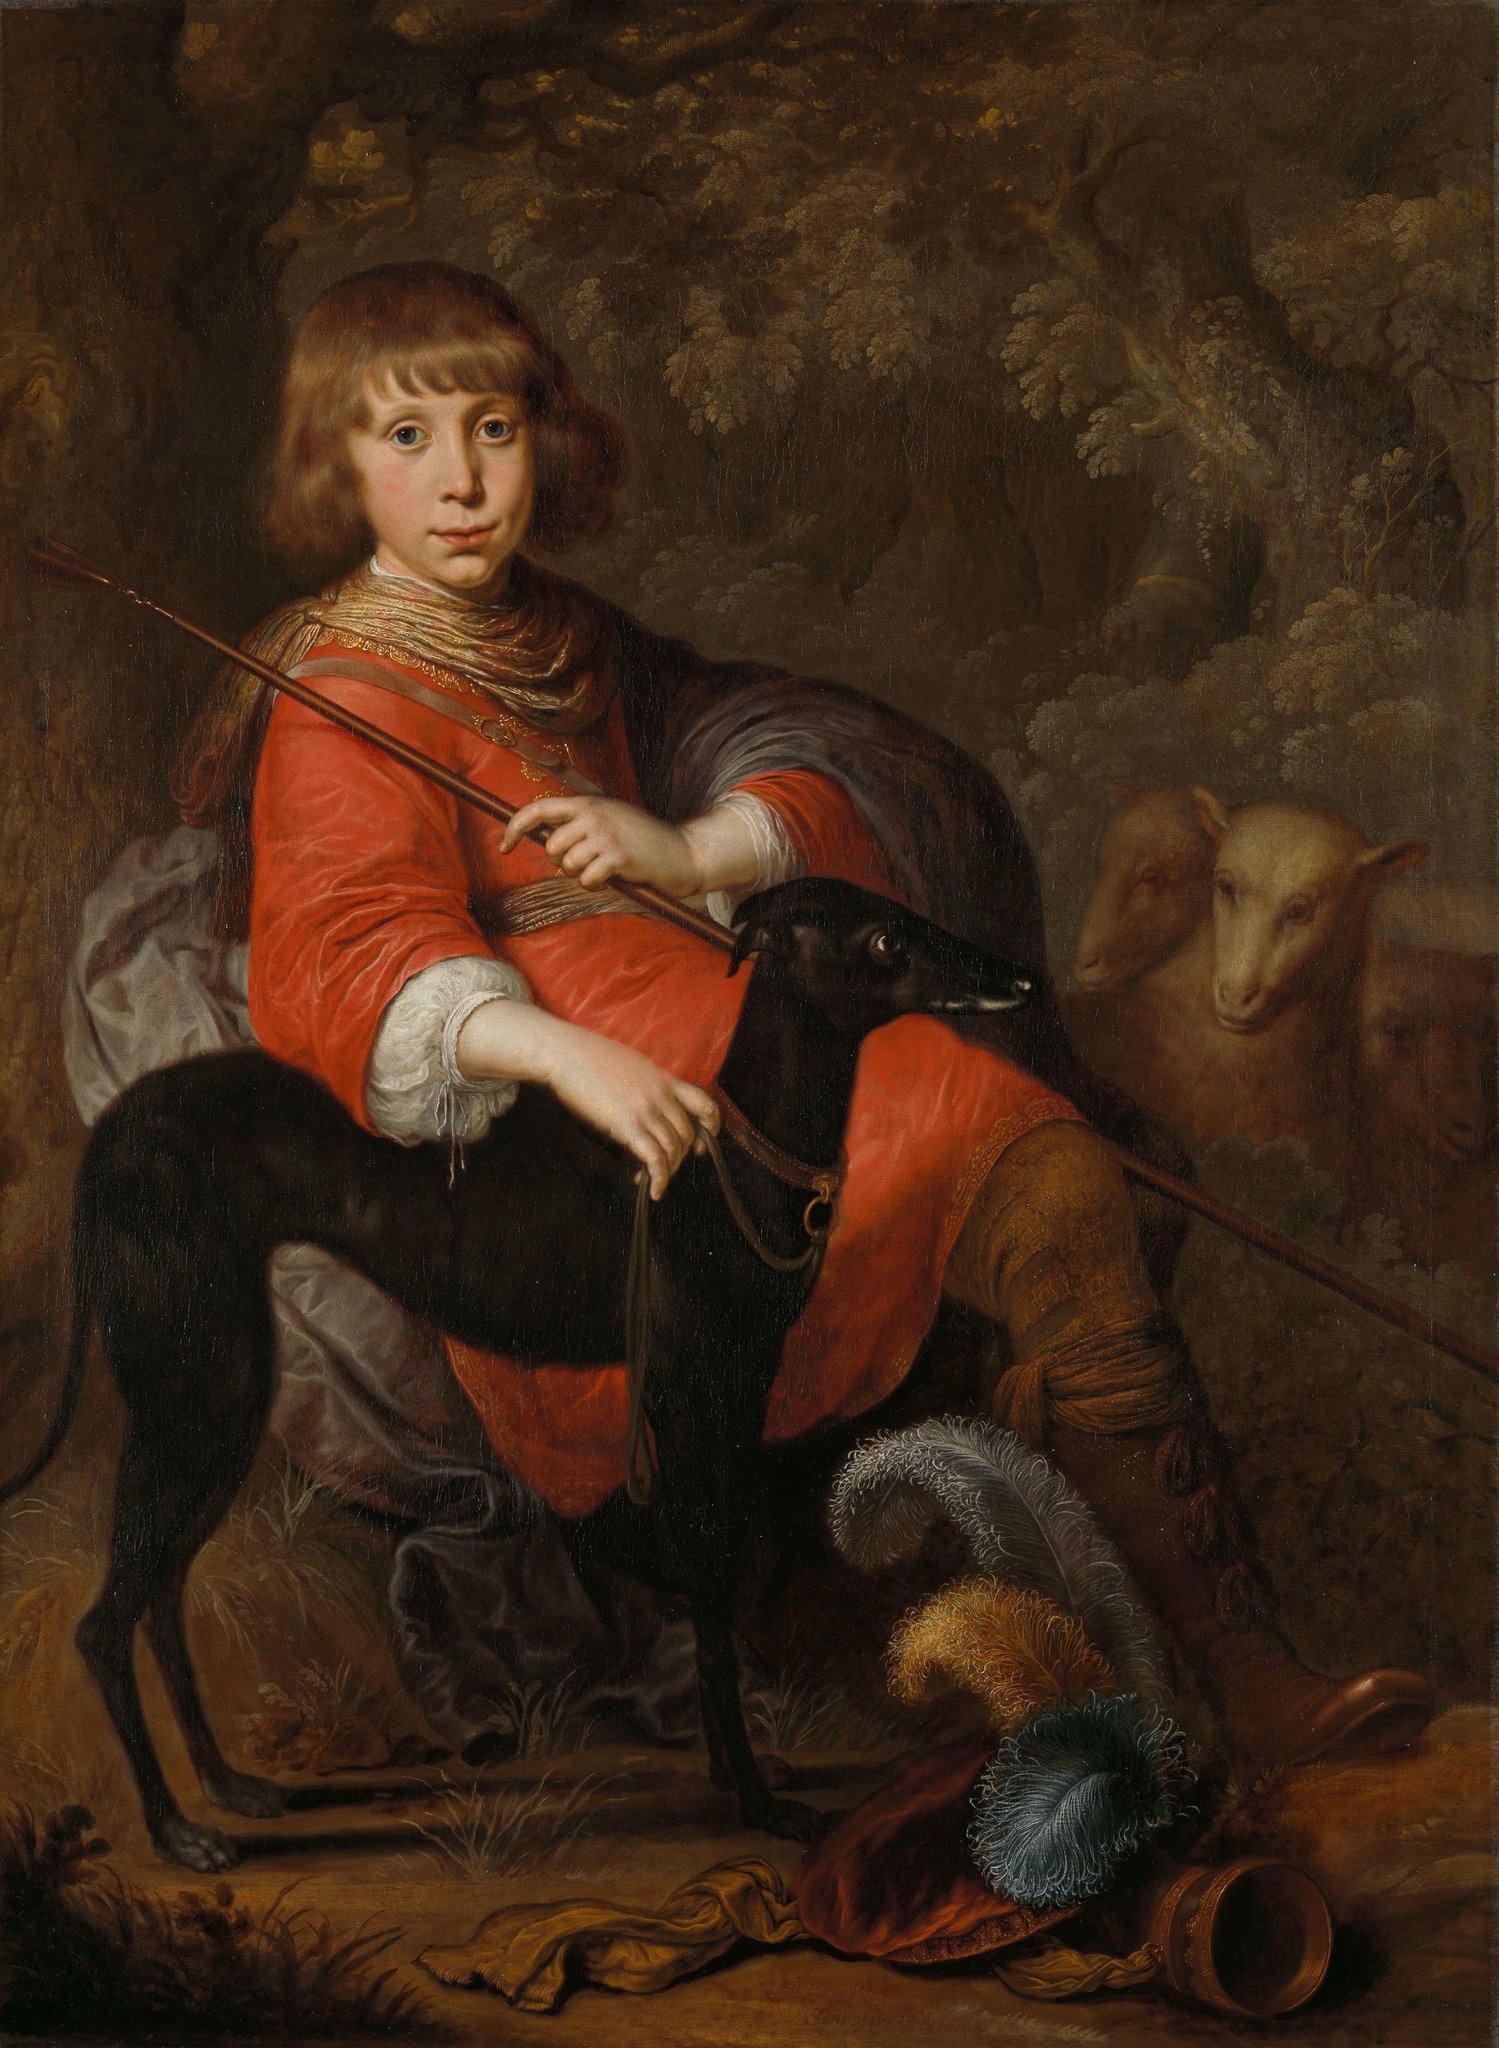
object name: painting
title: Portrait of Martinus Alewijn (1634-1684)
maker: dirck van santvoort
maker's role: draughtsman, painter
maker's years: 1610-1680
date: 1644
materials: canvas, oil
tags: herding, herdsman, herdswoman, shepherd, shepherdess, cowherd, etc., historical persons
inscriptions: signature and date, bottom centre: ‘Santvoort fe. 1644’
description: This canvas presents Martinus Alewijn, the ten-year-old son of an Amsterdam merchant. He is not simply eternalized in paint as the wealthy city boy that he was, but rather in the guise of a shepherd holding a staff sitting beneath a tree, with a dog and some sheep. These motifs reference country life and hunting. They underscore the family's prominent social standing and affluence.